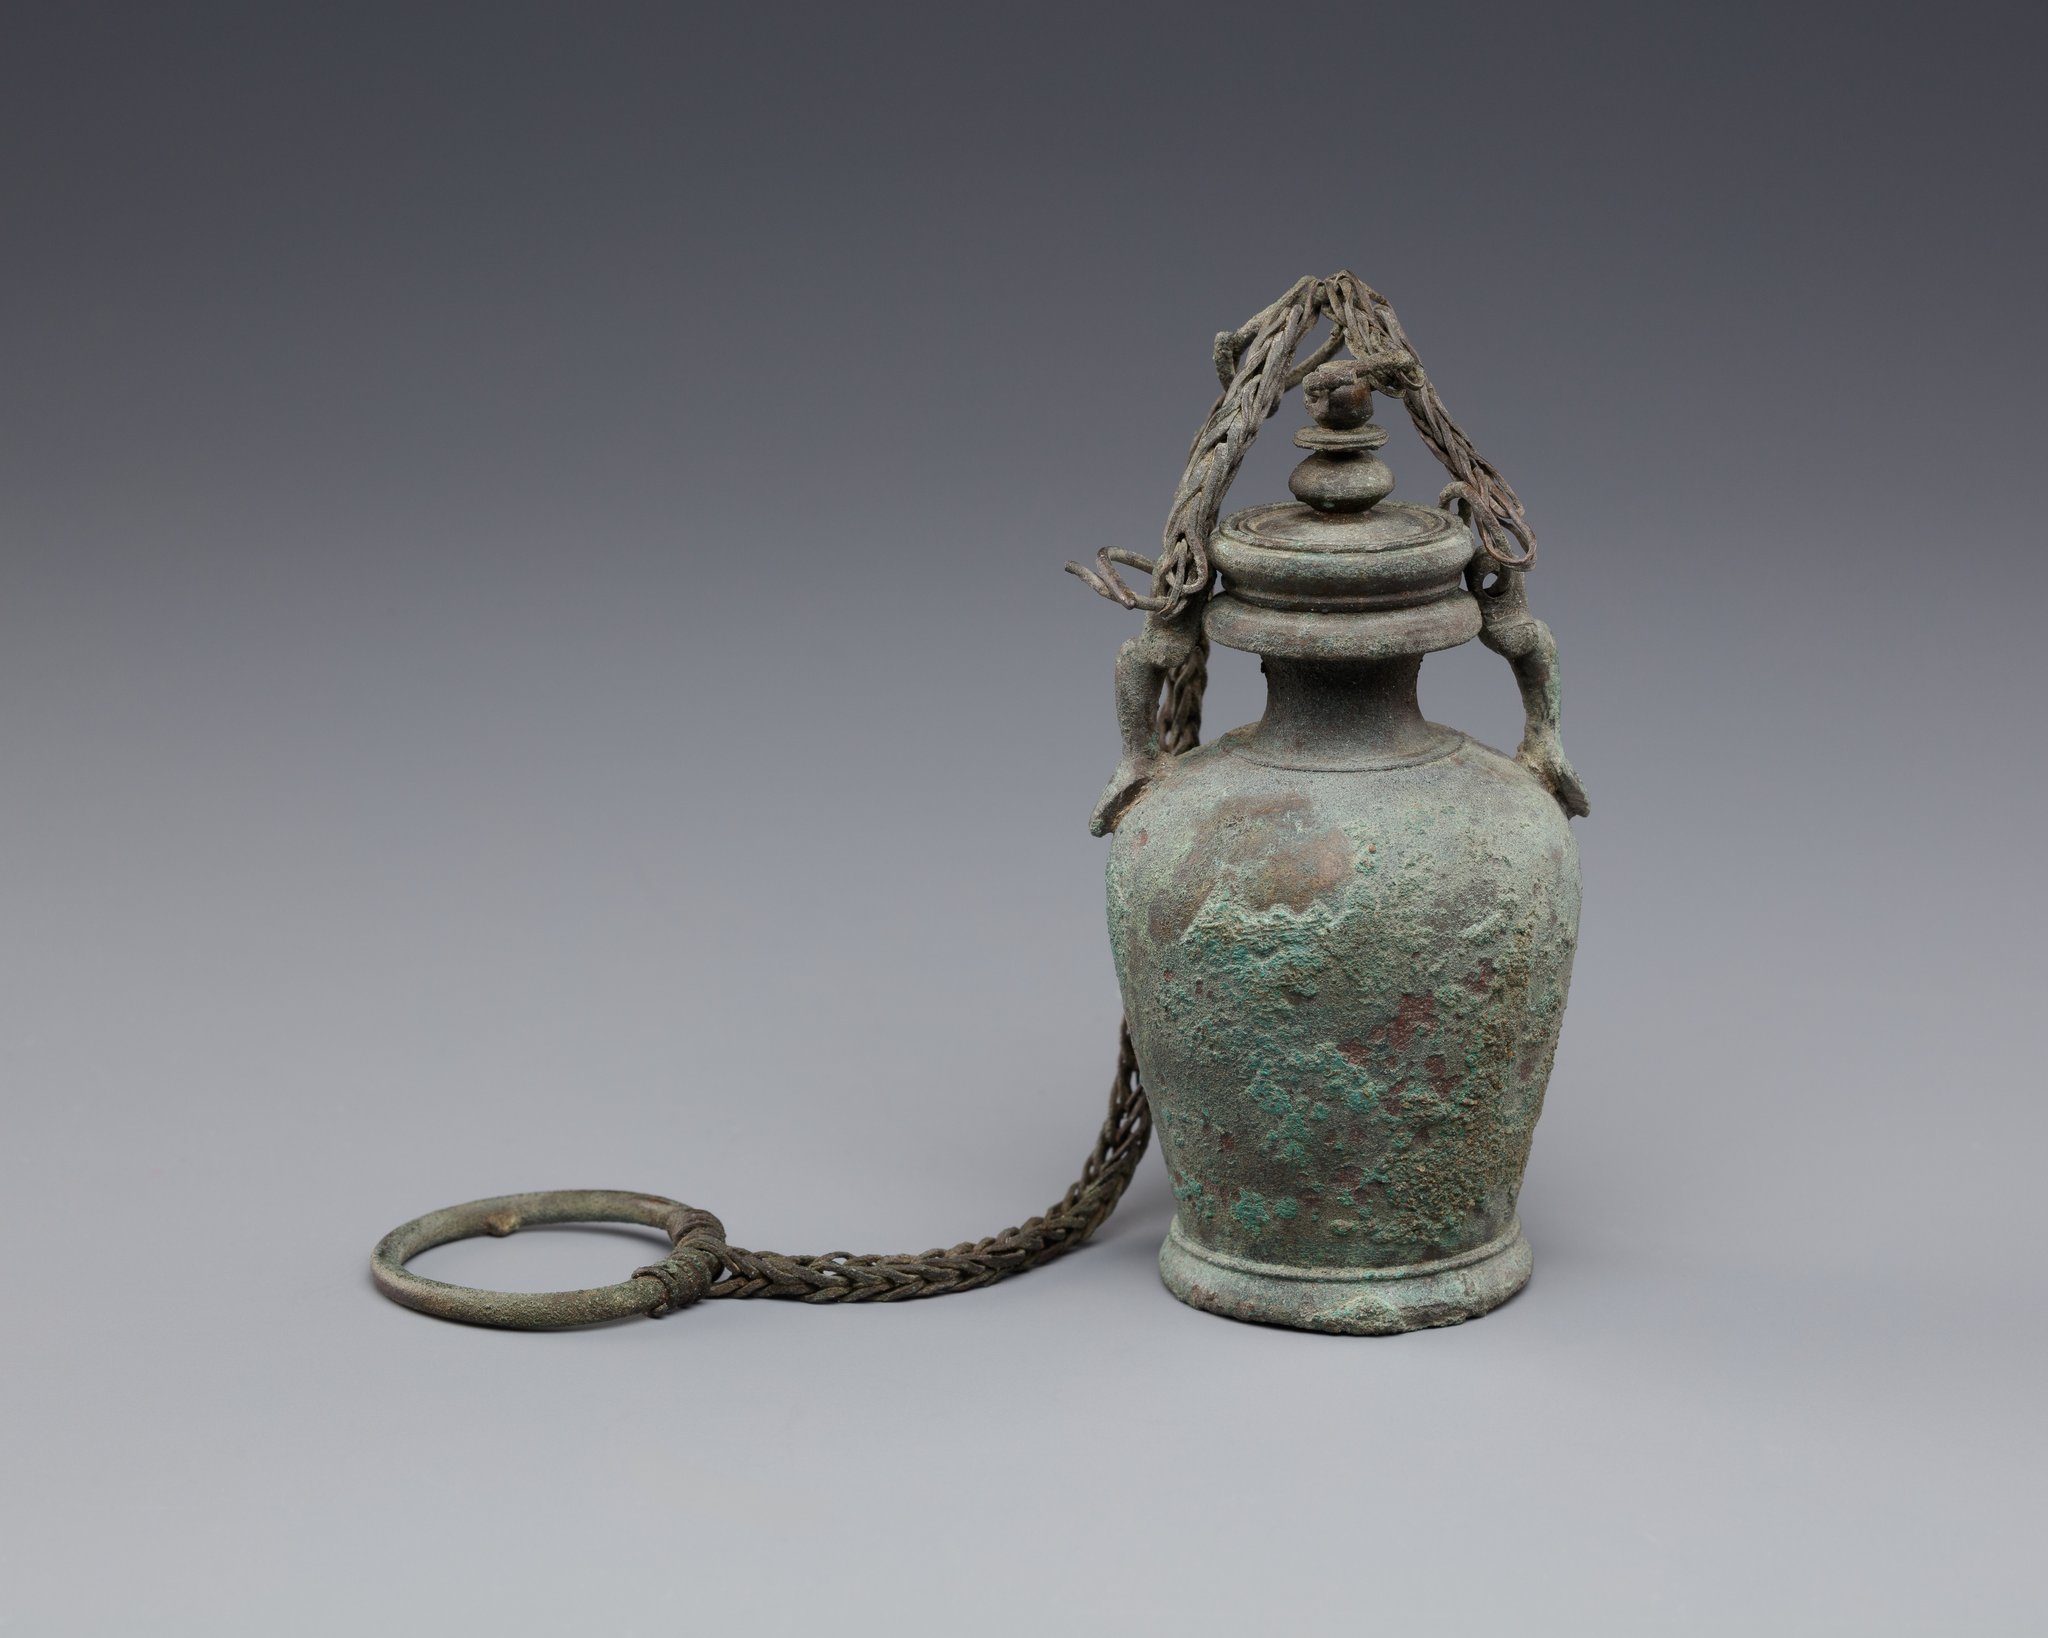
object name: bottle, stopper, suspension ring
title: Bottle with stopper and suspension ring, possibly intended for unguent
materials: bronze, copper alloy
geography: egypt